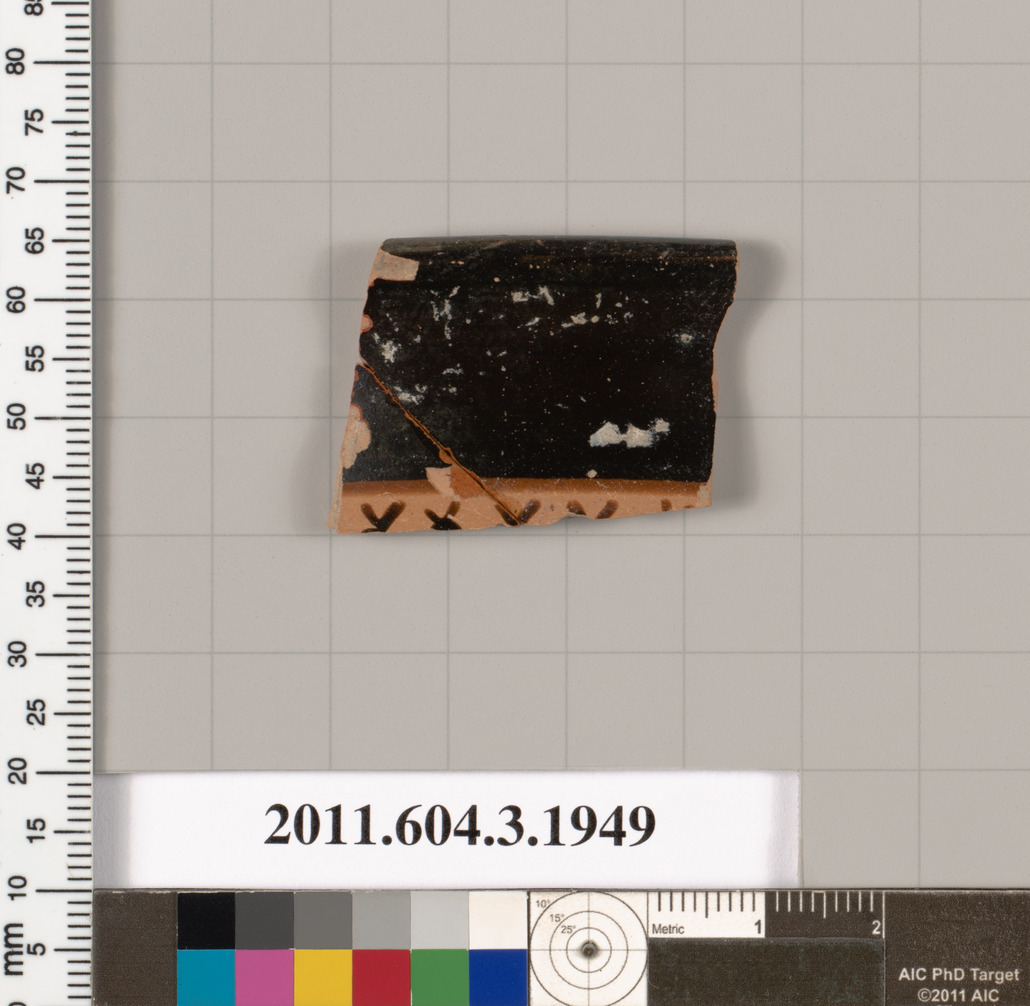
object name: kylix fragment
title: Terracotta fragment of a kylix: Droop cup (drinking cup)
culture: greek, attic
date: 567-535 BCE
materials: terracotta